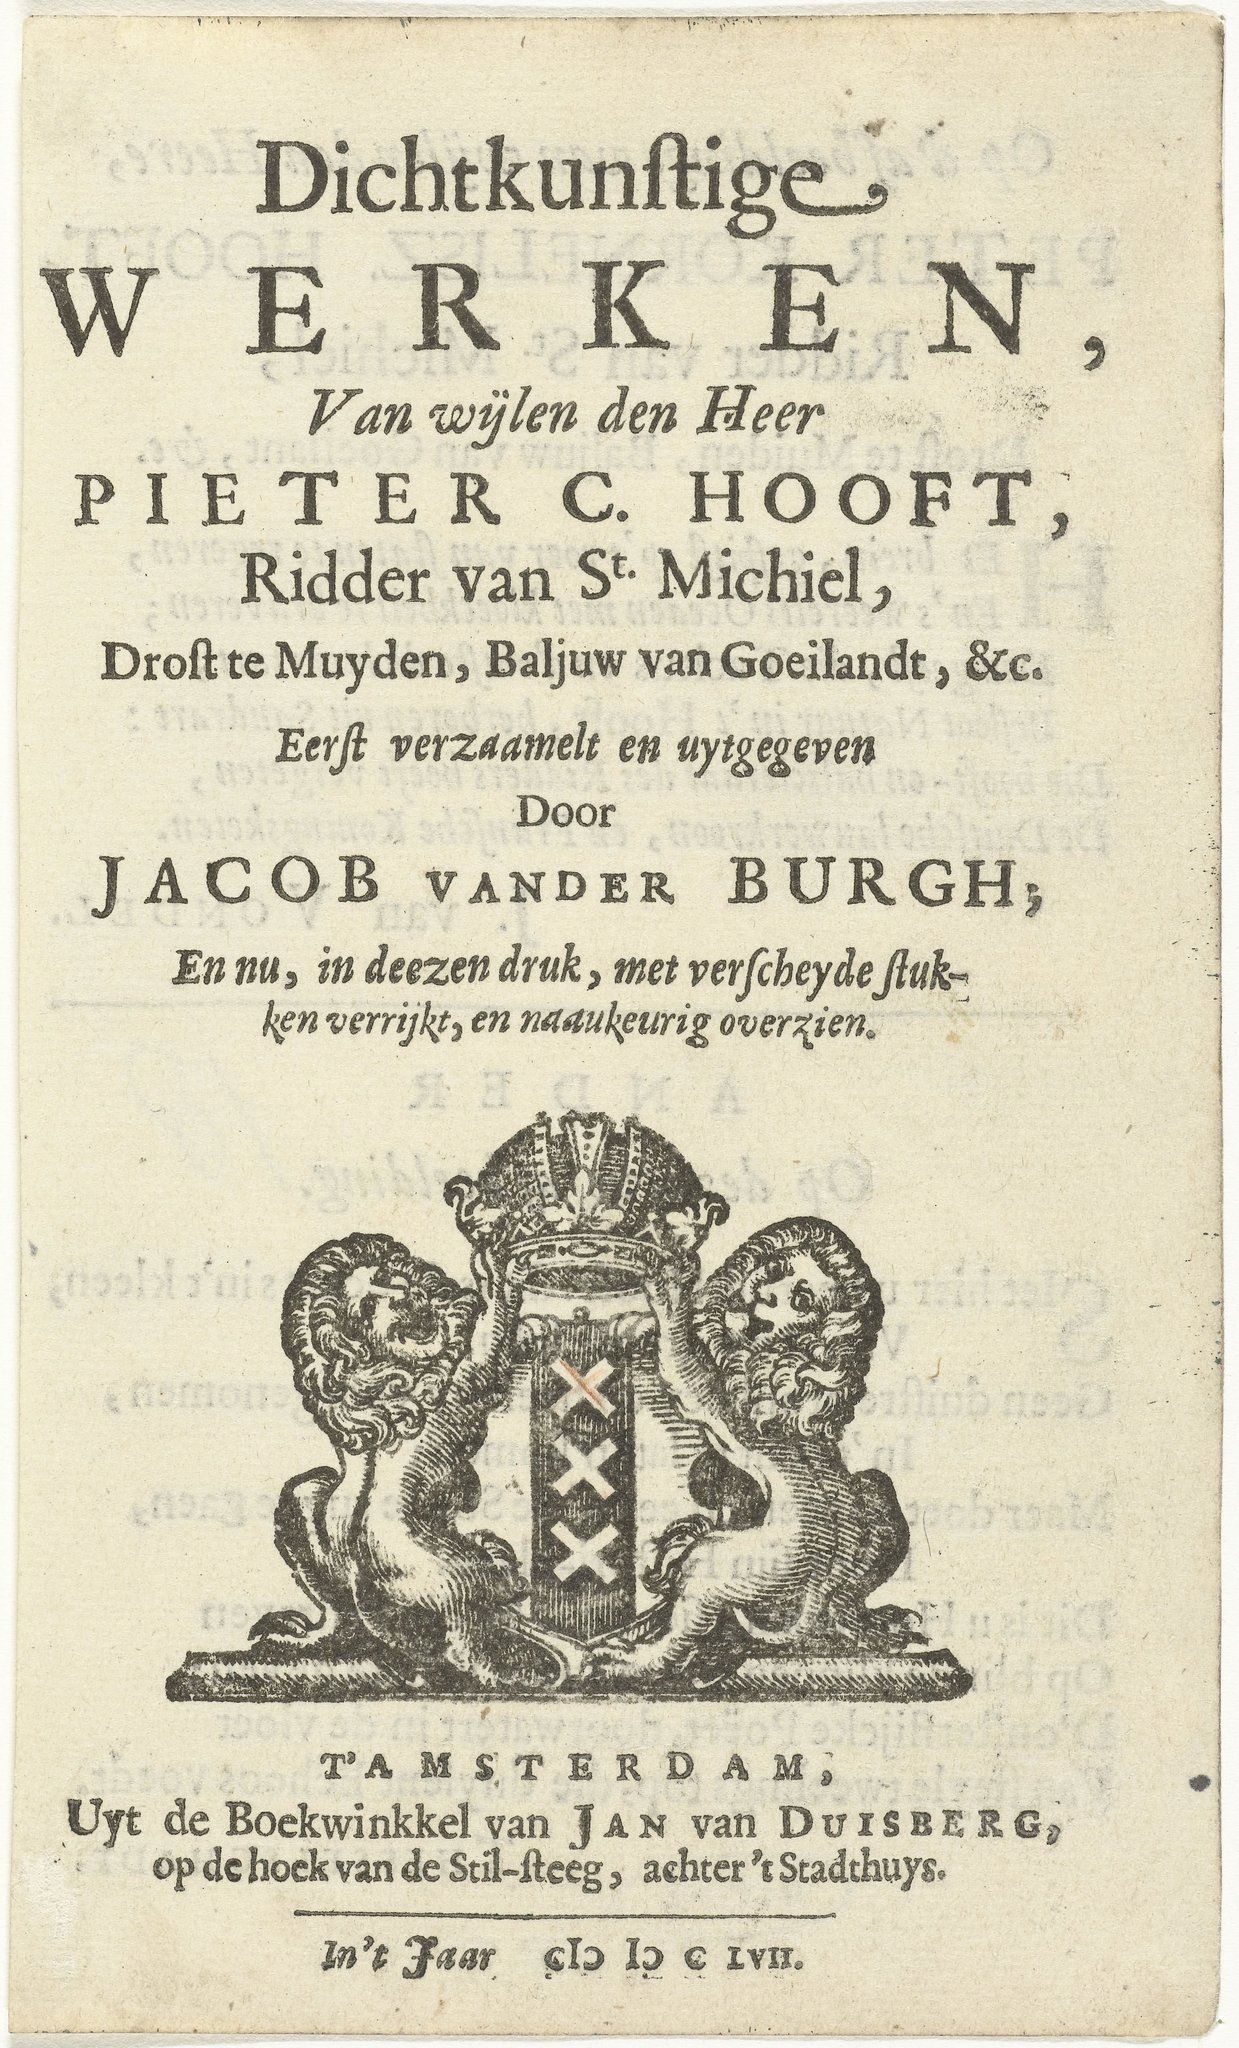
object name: text sheet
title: Dichtkunstige werken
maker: jan van duisberg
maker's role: publisher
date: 1657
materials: paper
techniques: engraving, letterpress printing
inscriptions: collector's mark: Lugt 2228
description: Titelpagina voor: P.C. Hooft, Dichtkunstige werken, Amsterdam, J. van Duisberg (verkoper), C. Cunradus (drukker), 1657. Op verso bijschriften voor portret van de dichter.